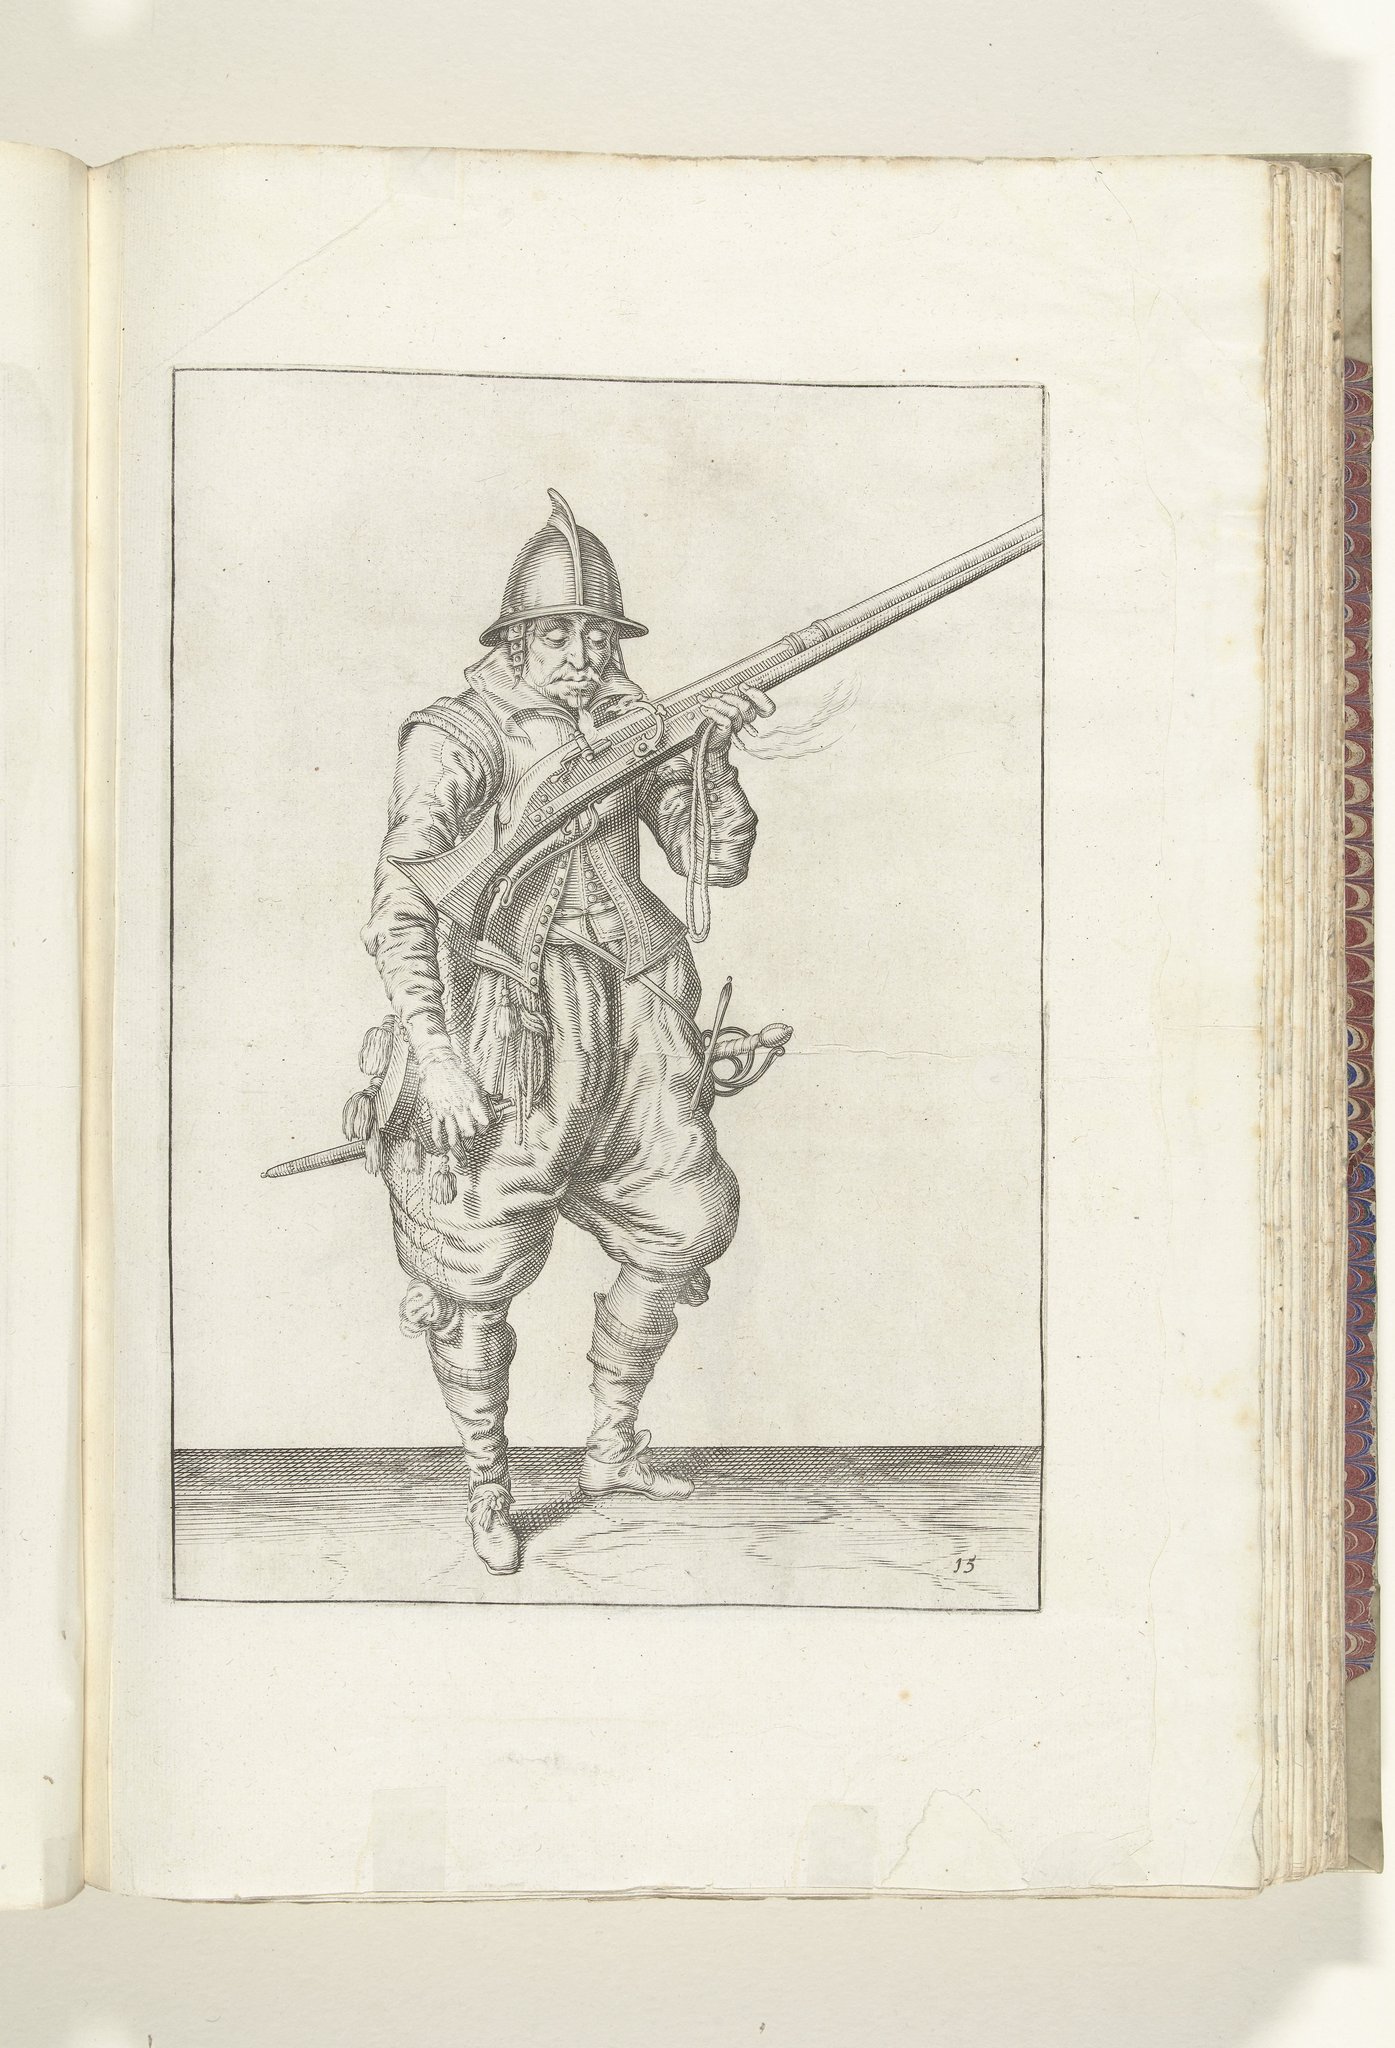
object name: print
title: Soldaat die vonken wegblaast van de pan van zijn roer (nr. 15), ca. 1600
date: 1597-1607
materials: paper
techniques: engraving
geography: northern netherlands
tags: maurice (prince of orange), handling of weapons ~ military training, weapons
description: Een soldaat, ten voeten uit, naar rechts, die een roer (een bepaald type vuurwapen) bij zijn mond houdt en over de pan (het kruitreservoir) blaast (nr. 15), ca. 1600. In zijn linkerhand behalve het roer ook een brandende lont. In zijn rechterhand een kruitfles. Plaat 15 in de instructies voor het hanteren van de roer. Onderdeel van de illustraties in: J. de Gheyn, Wapenhandelinghe van Roers Musquetten ende spiessen, Amsterdam, 1608. Krijgswezen rond 1600.